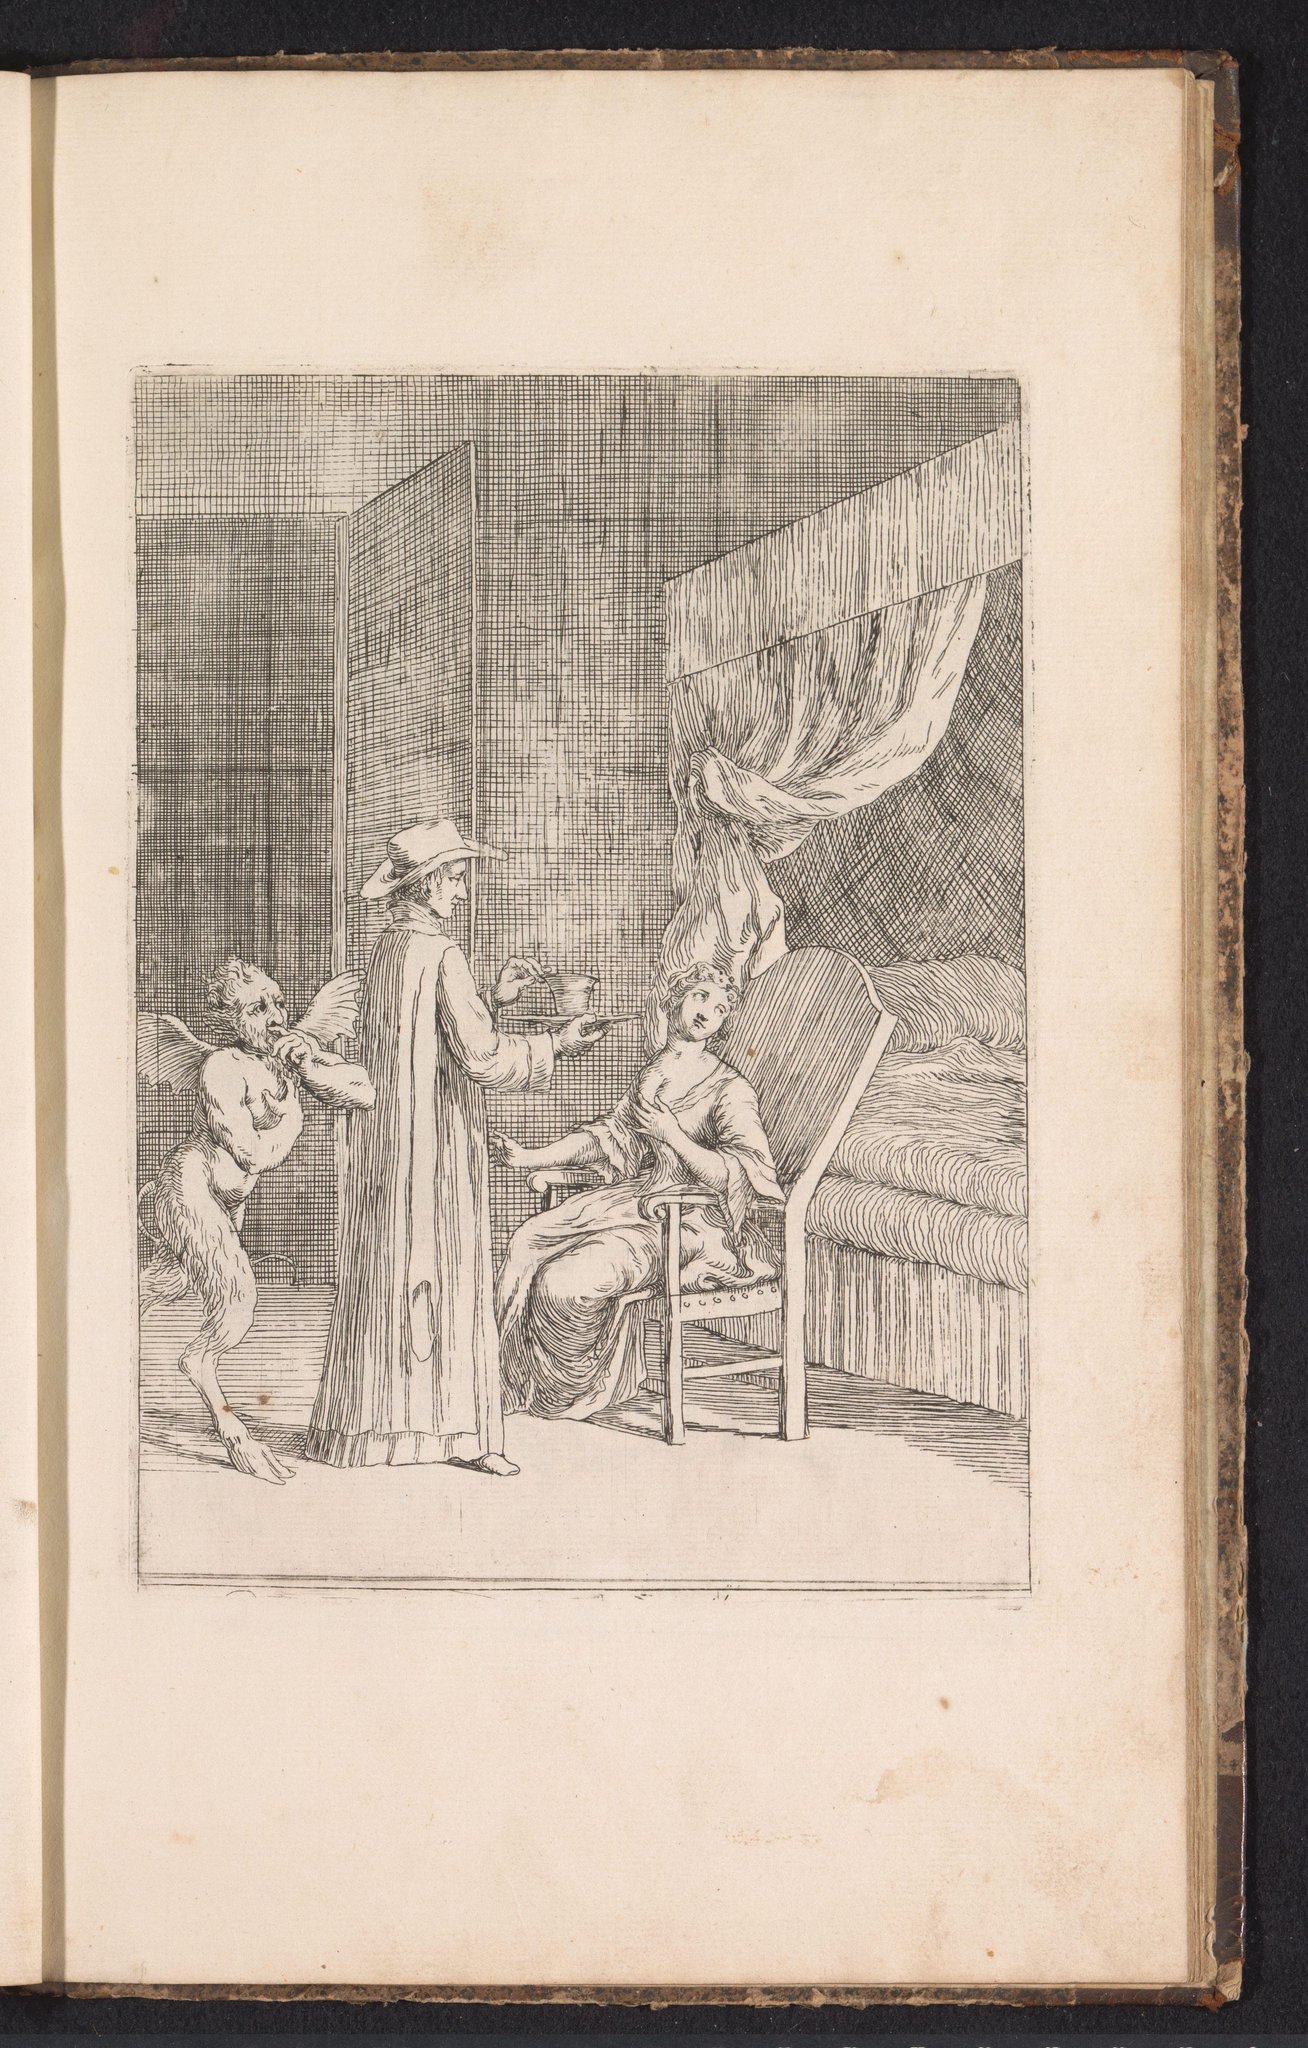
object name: print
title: Jean-Baptiste Girard dient de zwangere Marie-Catherine Cadière een drankje toe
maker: jacques gabriel huquier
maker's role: draughtsman, painter, print maker, publisher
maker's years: 1725-1805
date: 1735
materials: paper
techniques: etching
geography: france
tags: witch, sorcerer with the devil and/or demons, sexual abuses of monks, miscarriage, abortion, pregnancy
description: Jean-Baptiste Girard dient de zwangere Marie-Catherine Cadière een drankje toe wat een eind zal maken aan haar zwangerschap. Onderdeel van de reeks van 32, veelal erotisch getinte, prenten gewijd aan het schandaal rond Marie-Catherine Cadière en de Jezuïet Jean-Baptiste Girard in 1730-1731.